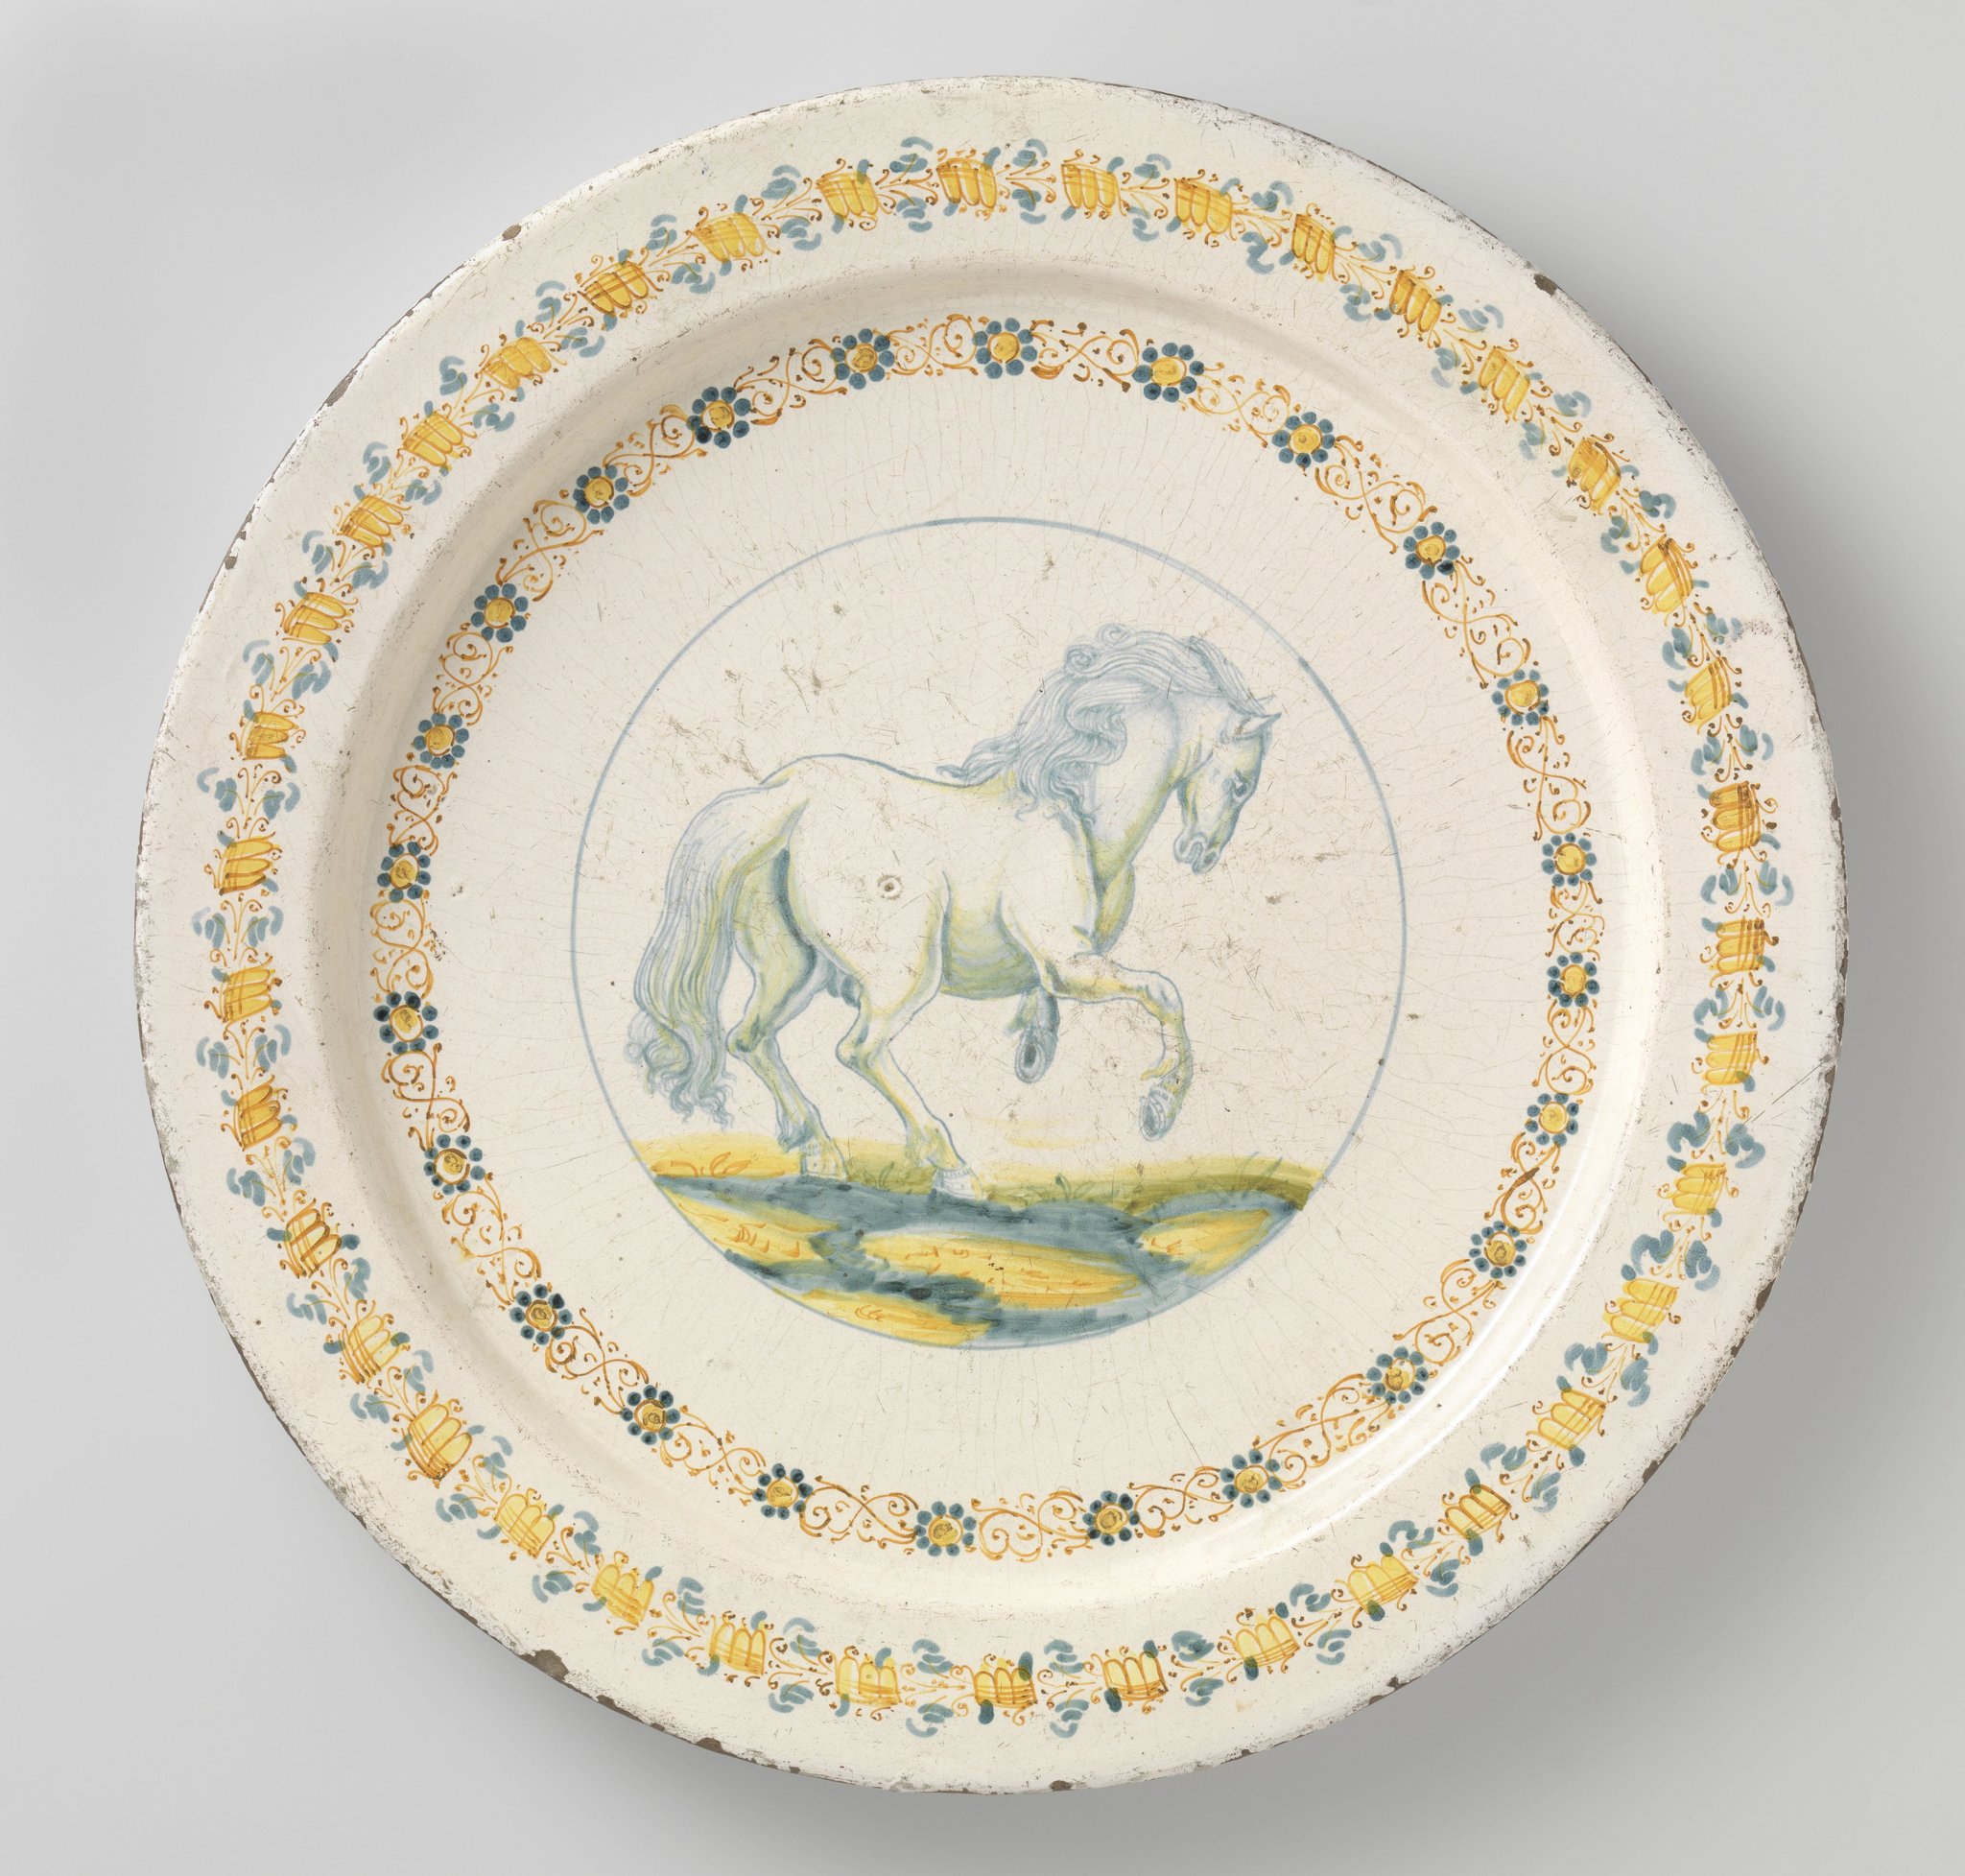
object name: platter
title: Schotel van veelkleurig beschilderde faience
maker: Anonymous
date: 1580-1640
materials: earthenware, glaze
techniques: painted, polychromy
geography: italy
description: Dish. Maiolica. Castelli, c. 1560 - 1580.